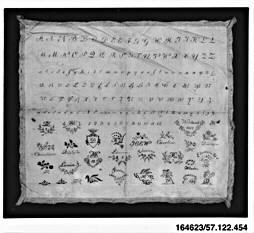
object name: sampler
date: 1812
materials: cotton